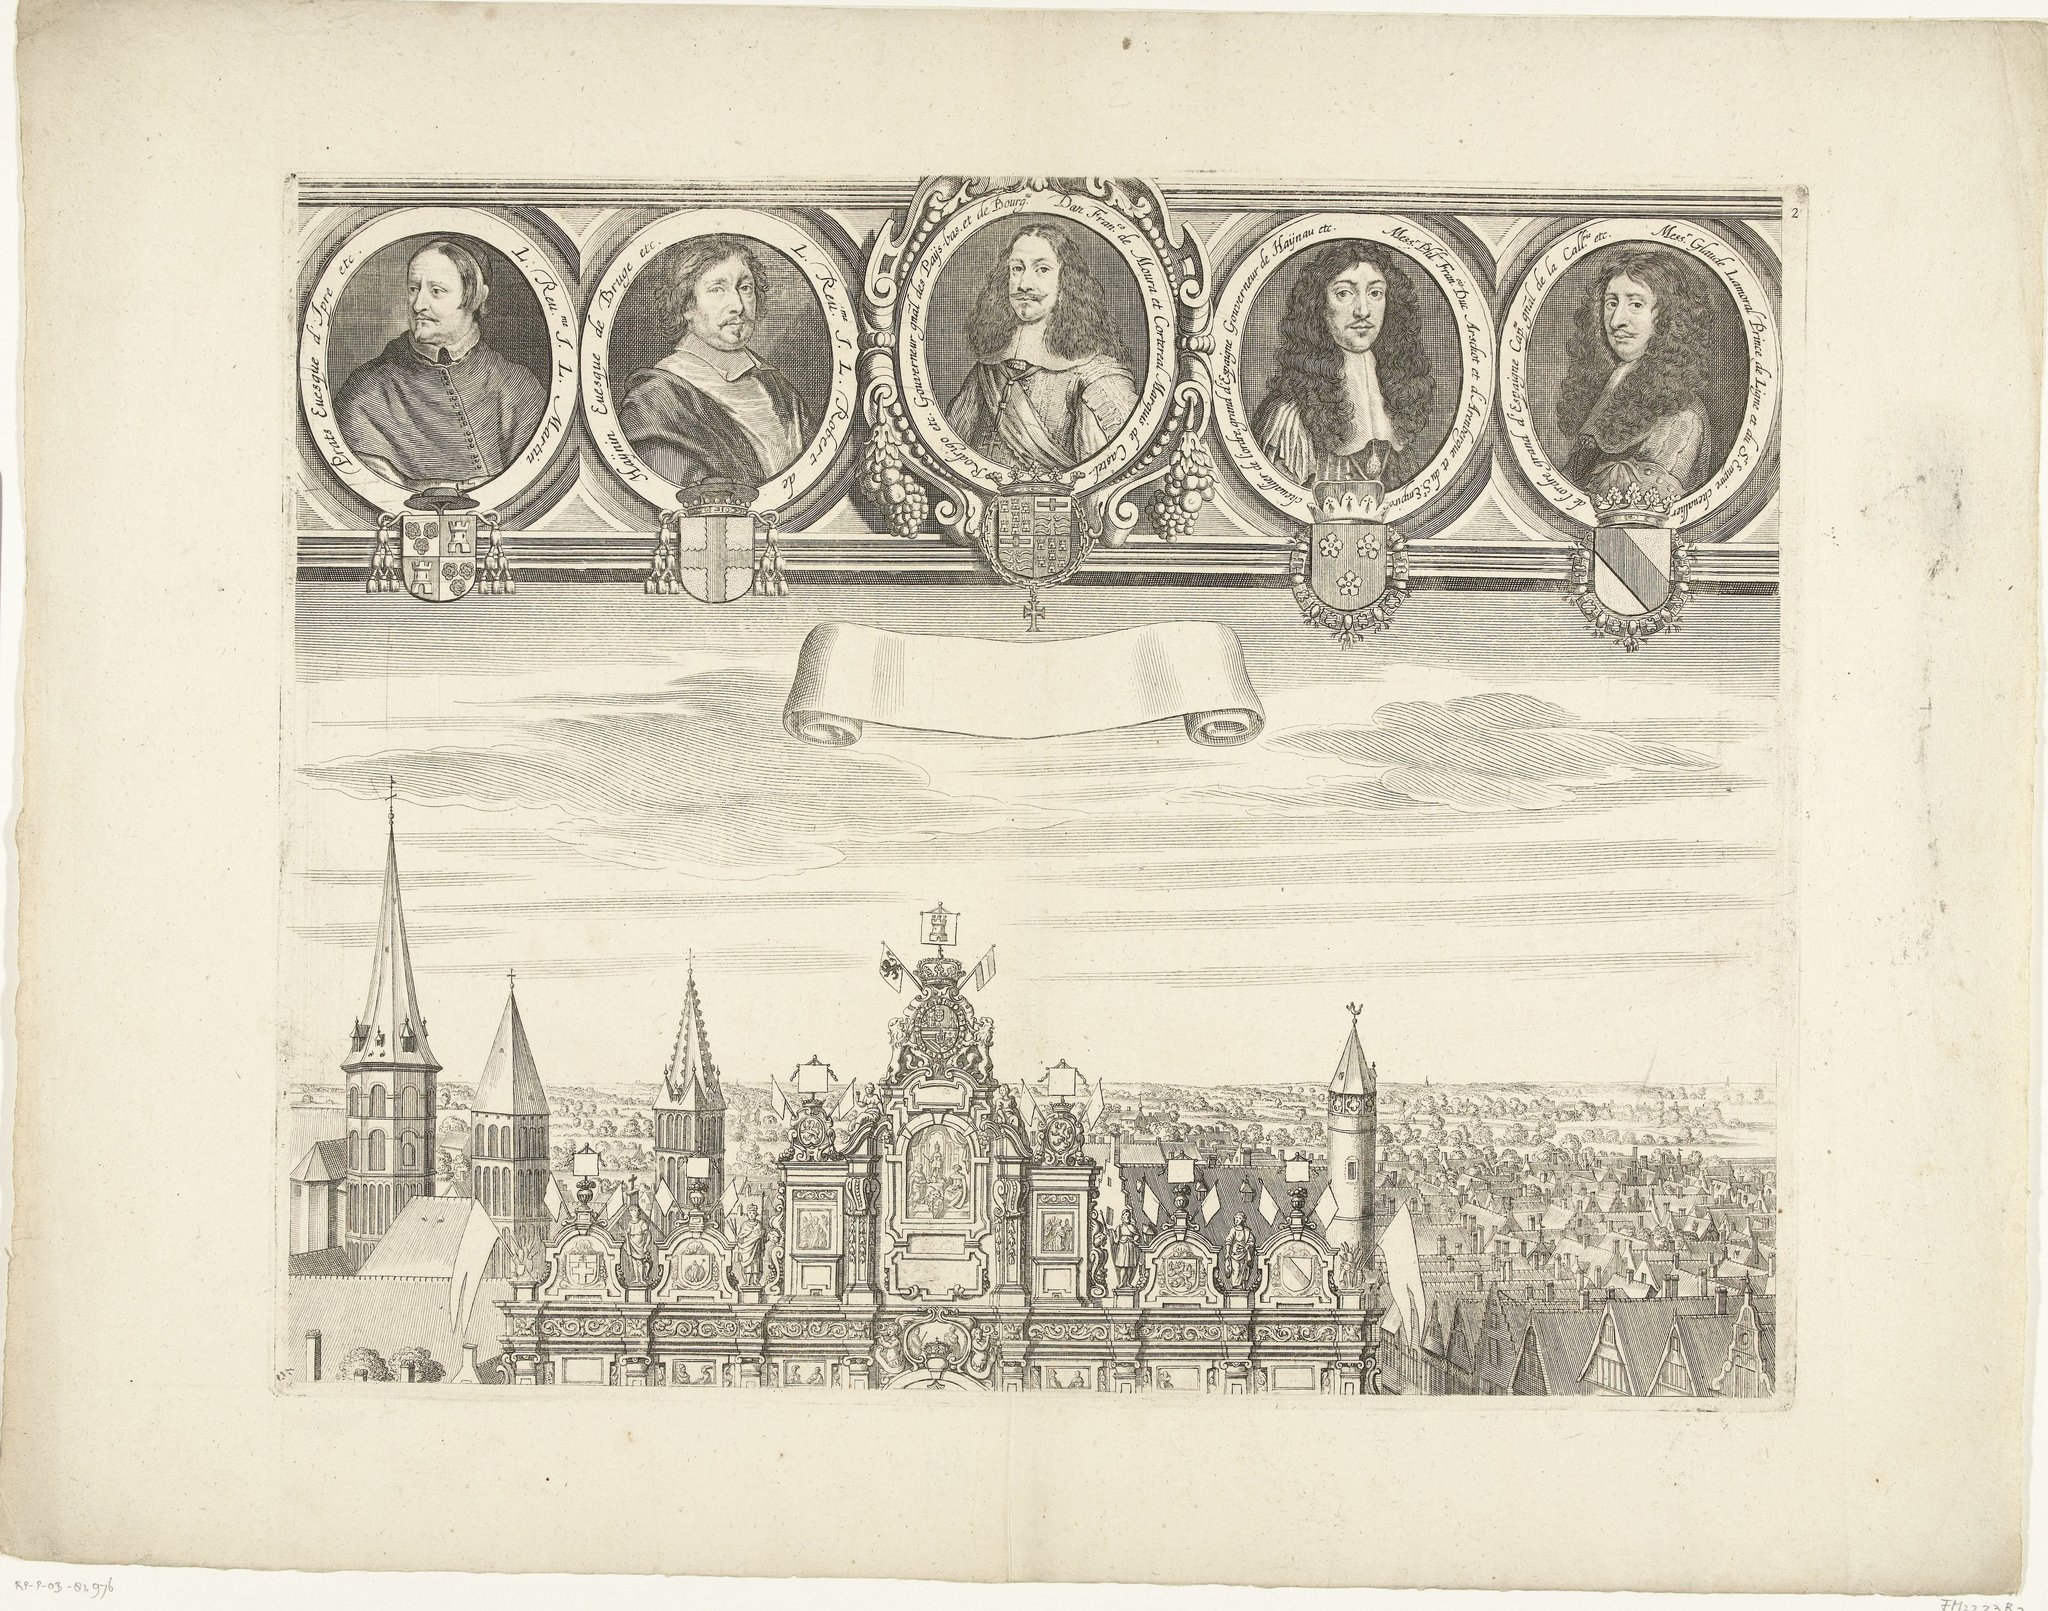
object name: print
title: Proclamatie te Gent van Karel II van Spanje als graaf van Vlaanderen (blad 2), 1666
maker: lucas vorsterman (ii)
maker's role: print maker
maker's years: 1624-1667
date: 1666-1667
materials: paper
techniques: engraving, etching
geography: southern netherlands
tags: karel ii (koning van spanje), ceremonial procession, parade, pageant ~ installation of a ruler, festivities (+ parade, pageant, cavalcade ~ festive activities)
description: Ceremonie op de Vrijdagmarkt te Gent bij de proclamatie van de Spaanse koning Karel II als graaf van Vlaanderen, 2 mei 1666. Blad 2 in een ongemonteerde ensemble van 12 platen van de ceremonie en cavalcade op het plein en 118 portretten van de hoogwaardigheidsbekleders die bij de plechtigheid aanwezig waren. Genummerd rechtsboven: 2.